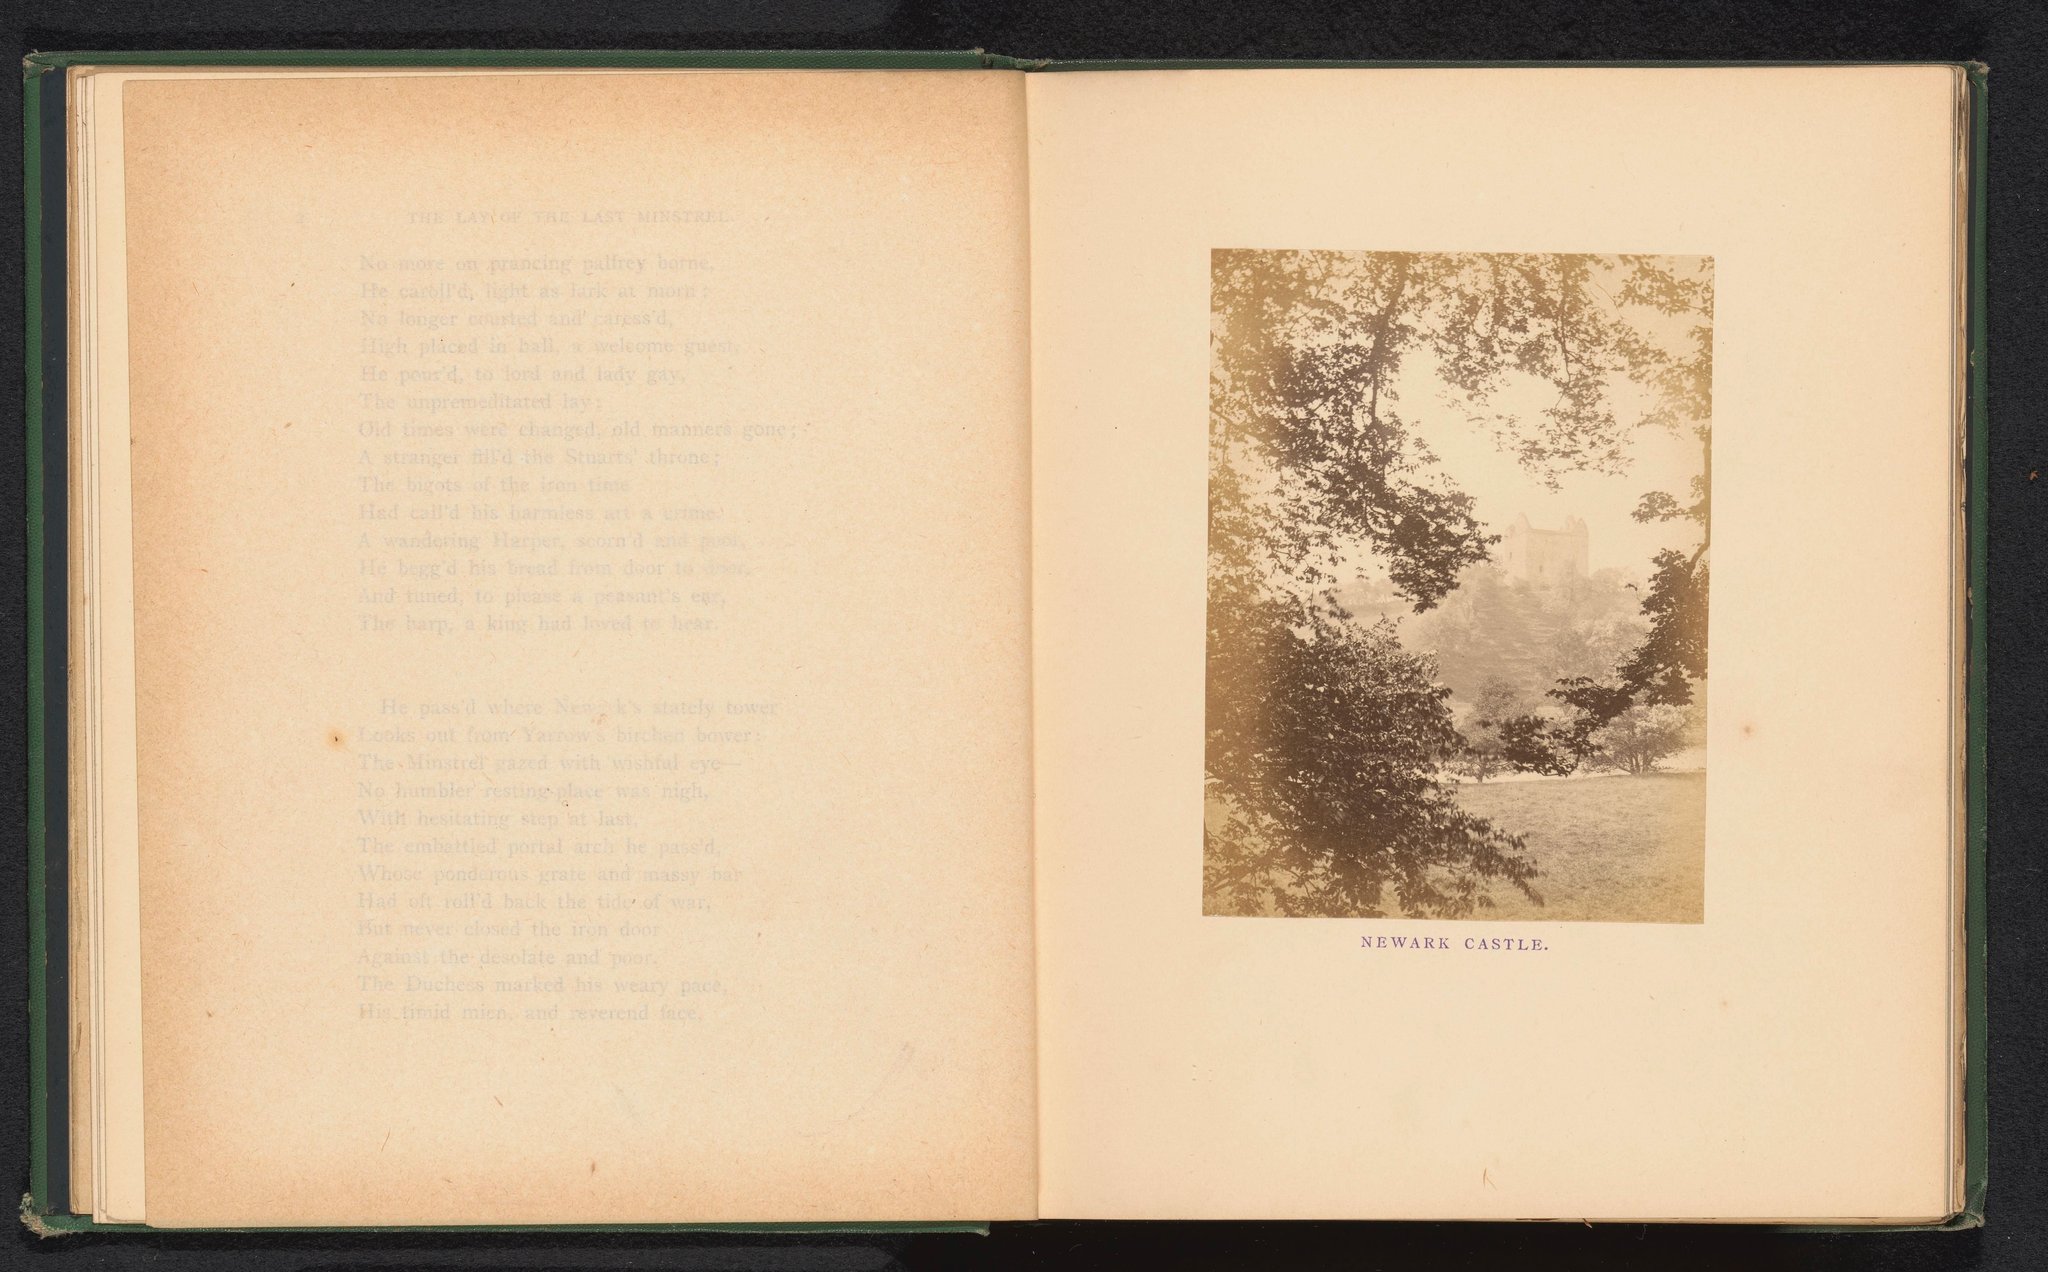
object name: page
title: Newark Castle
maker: william russell sedgfield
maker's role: fotograaf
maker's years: 1826-1902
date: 1862-1872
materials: photographic support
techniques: albumen print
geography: nottinghamshire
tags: castle